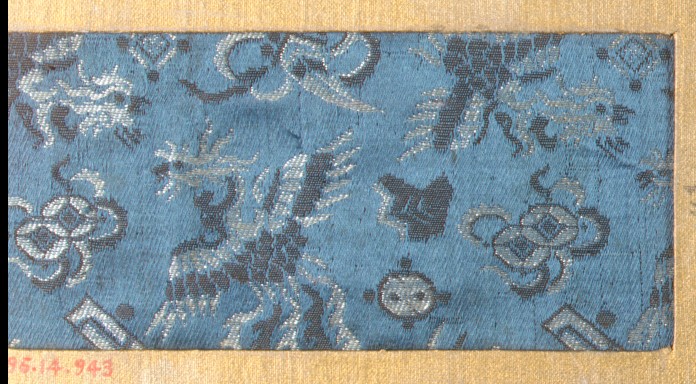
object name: piece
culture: japanese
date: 1701-1900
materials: silk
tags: phoenix